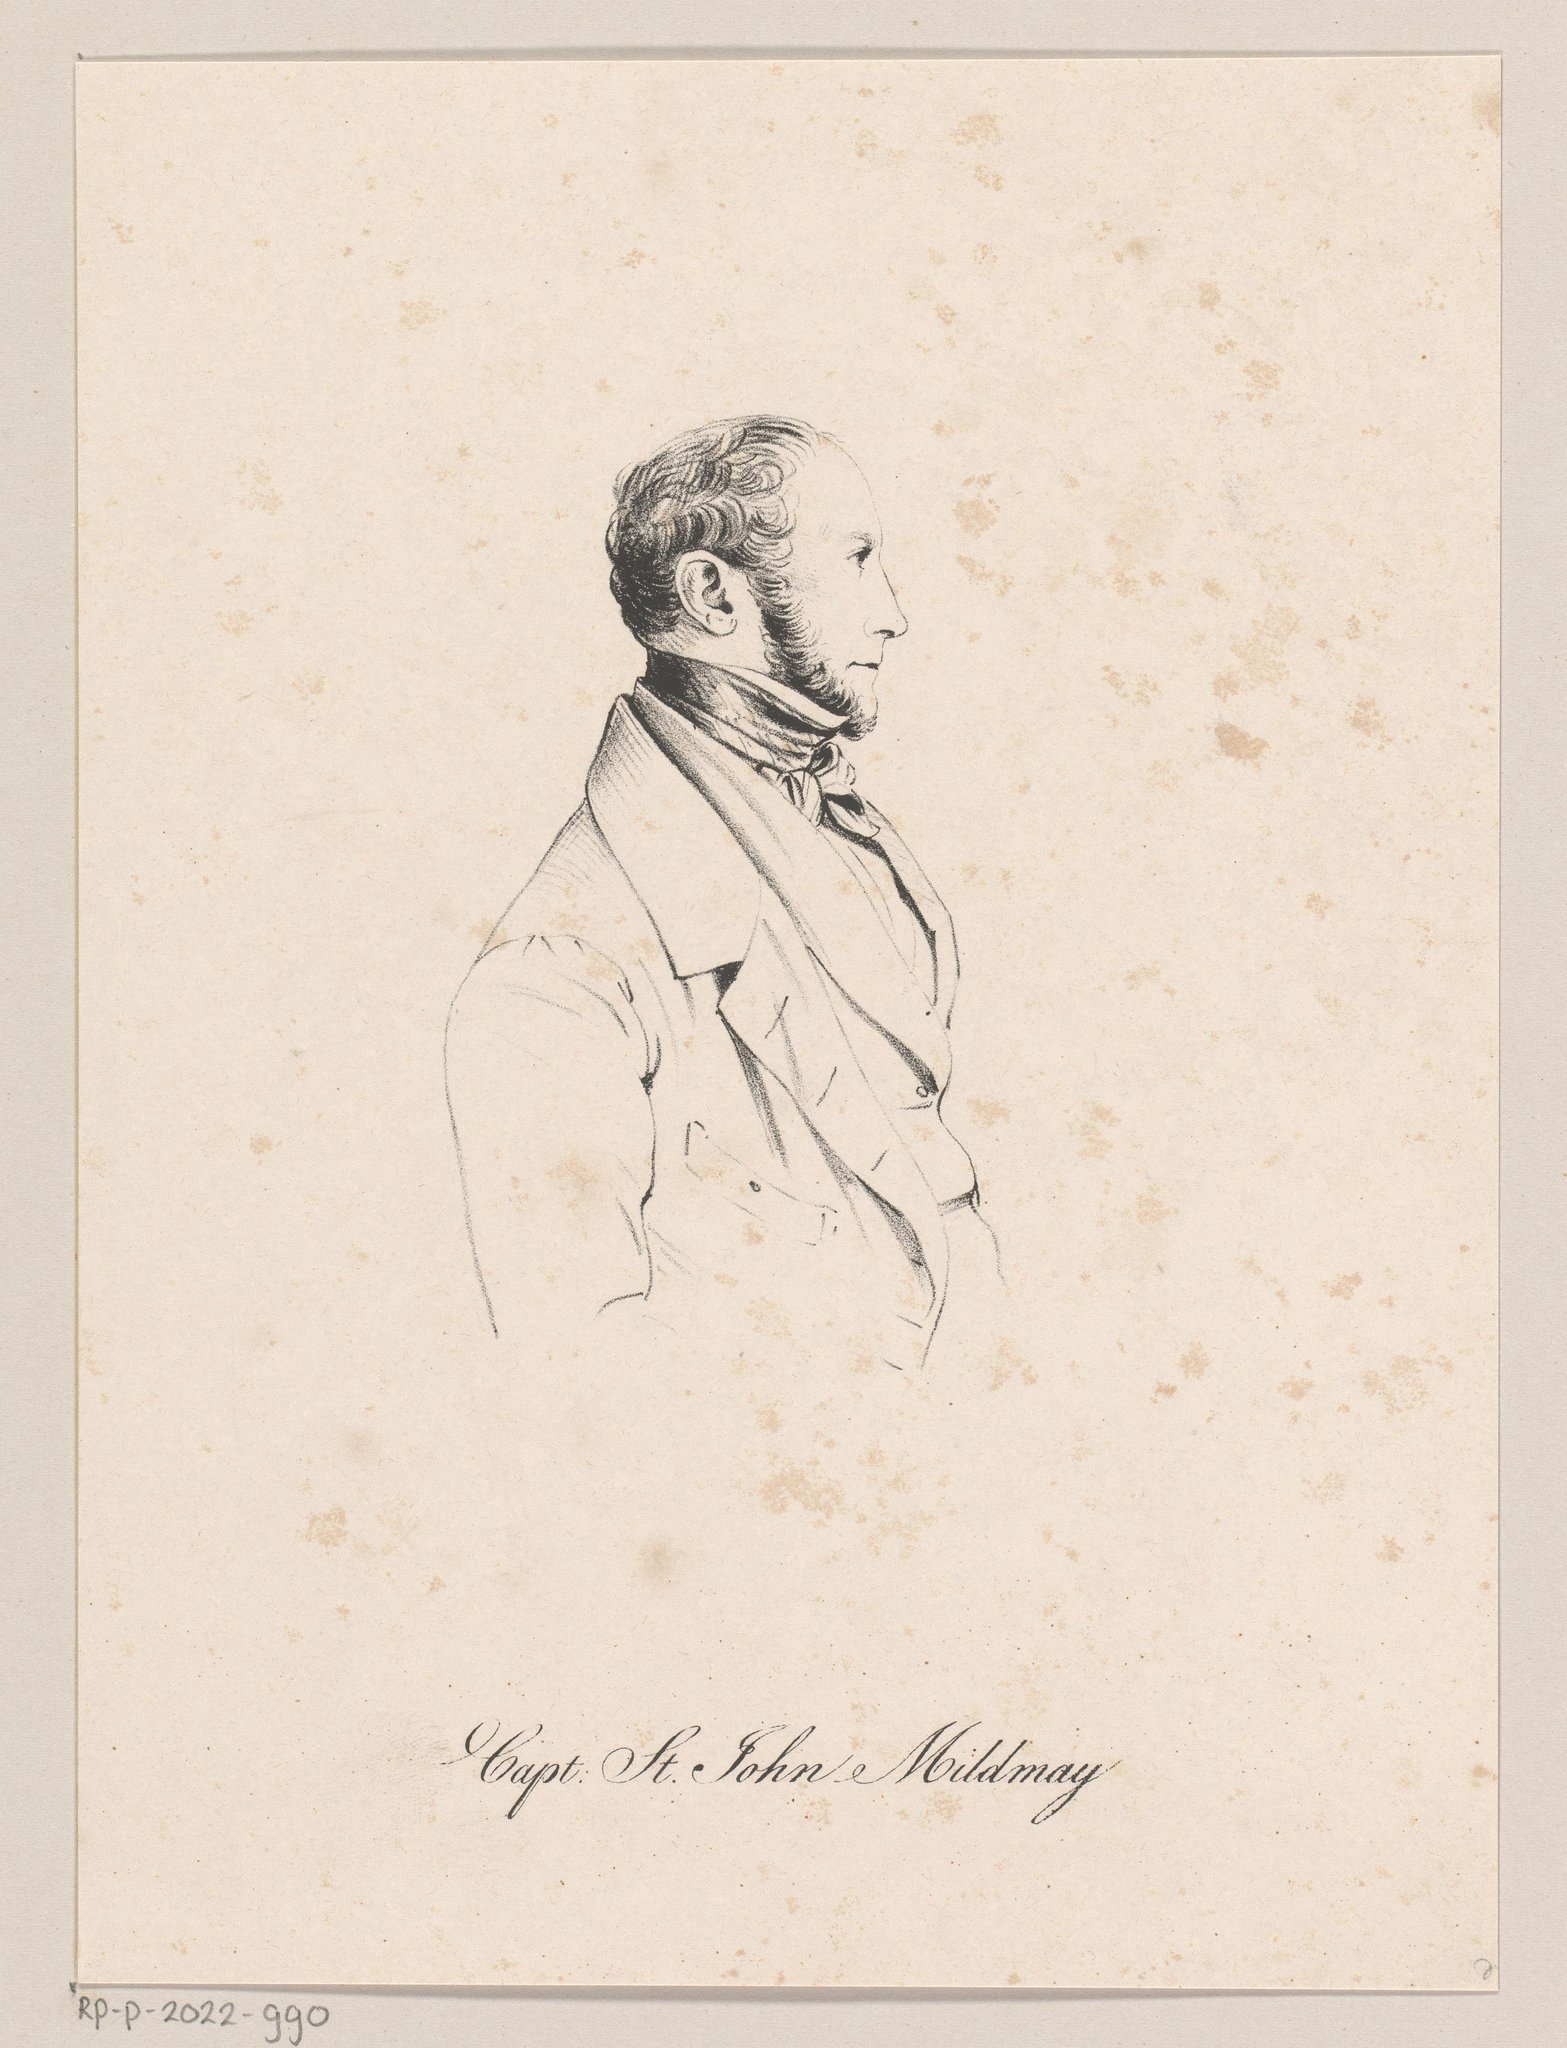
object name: print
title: Portret van Edmond St. John-Mildmay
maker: Anonymous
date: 1840-1900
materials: paper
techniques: lithograph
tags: historical persons, officer